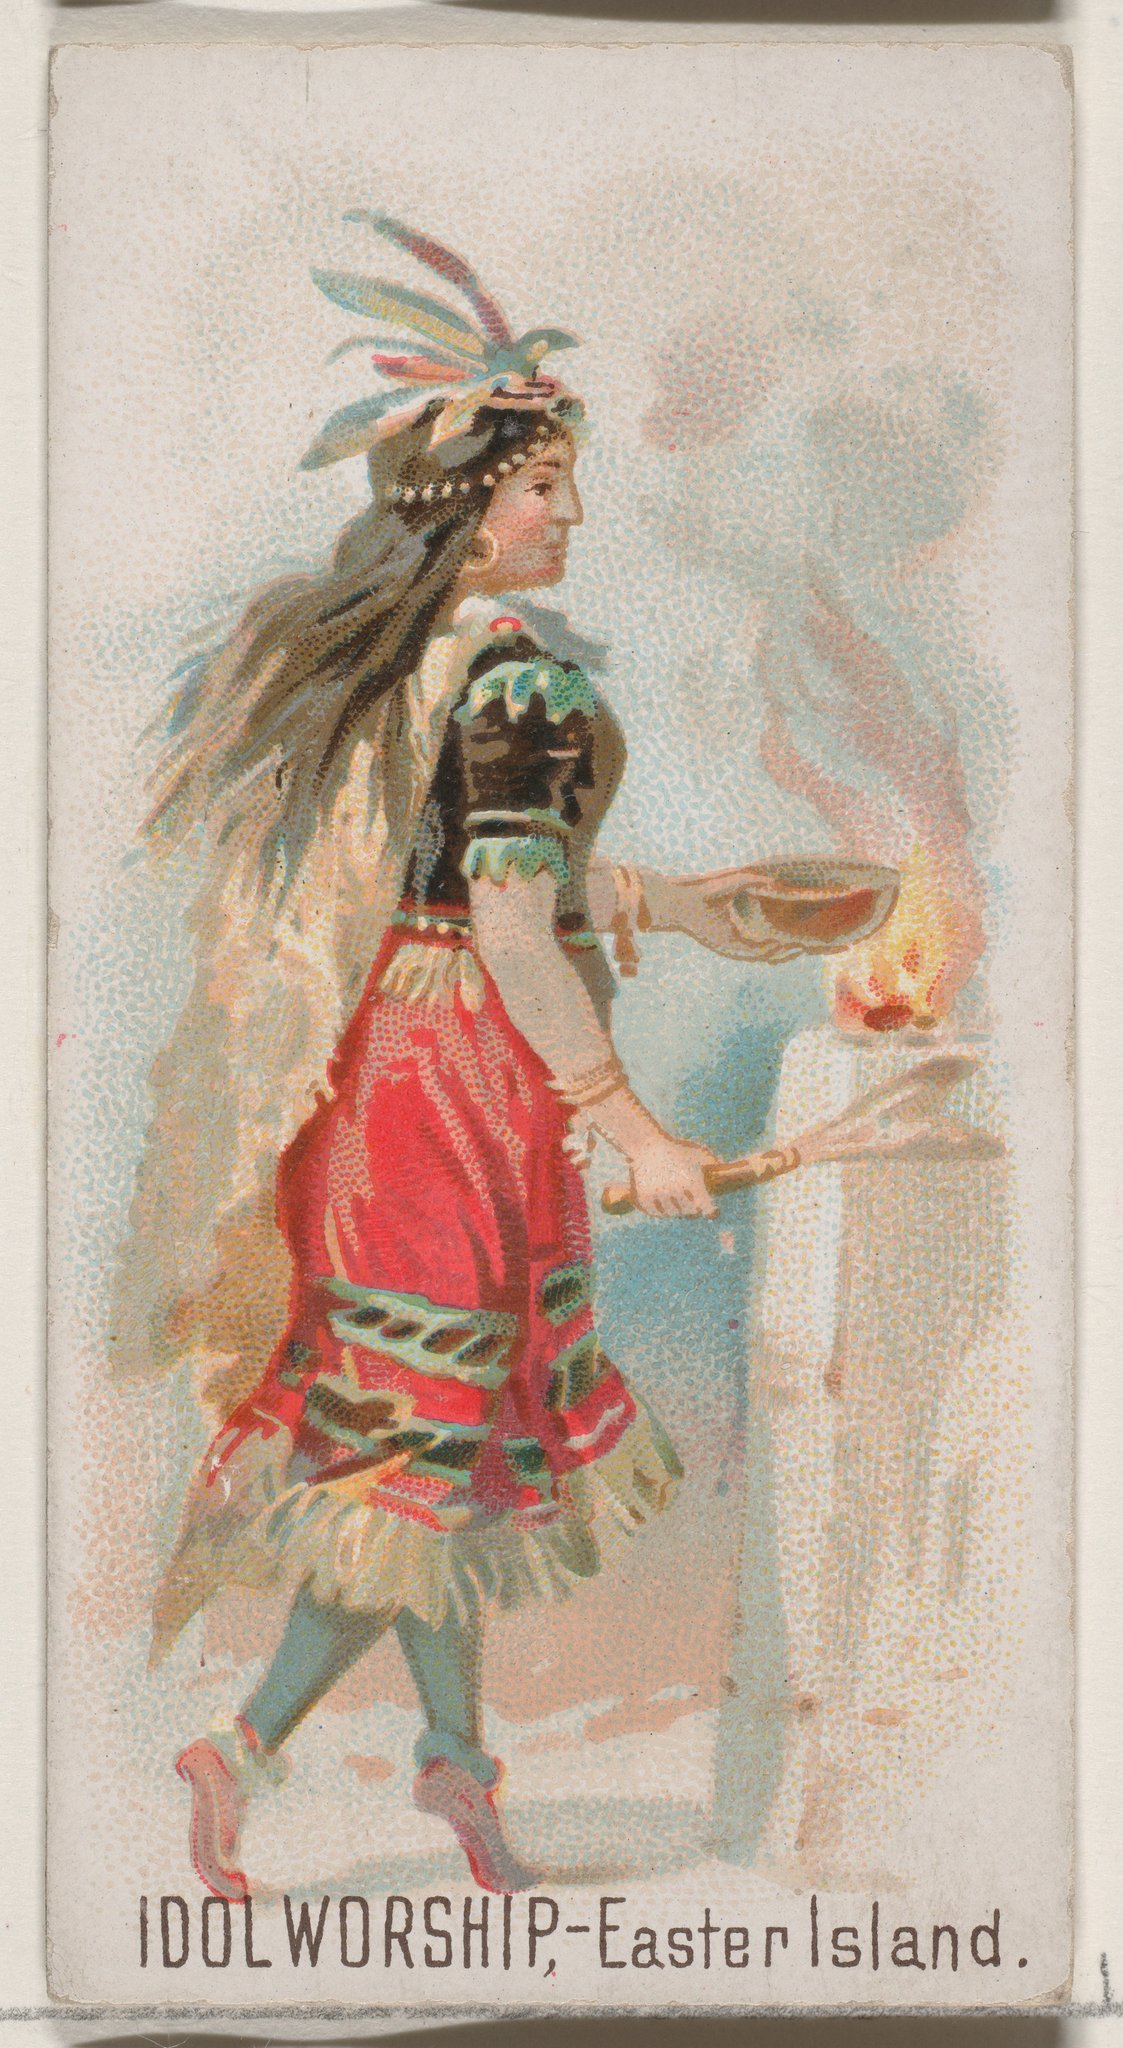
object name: print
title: Idol Worship, Easter Island, from the Holidays series (N80) for Duke brand cigarettes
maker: w. duke, sons & co.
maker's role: publisher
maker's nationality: american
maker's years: 1870-1920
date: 1890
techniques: color lithograph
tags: women